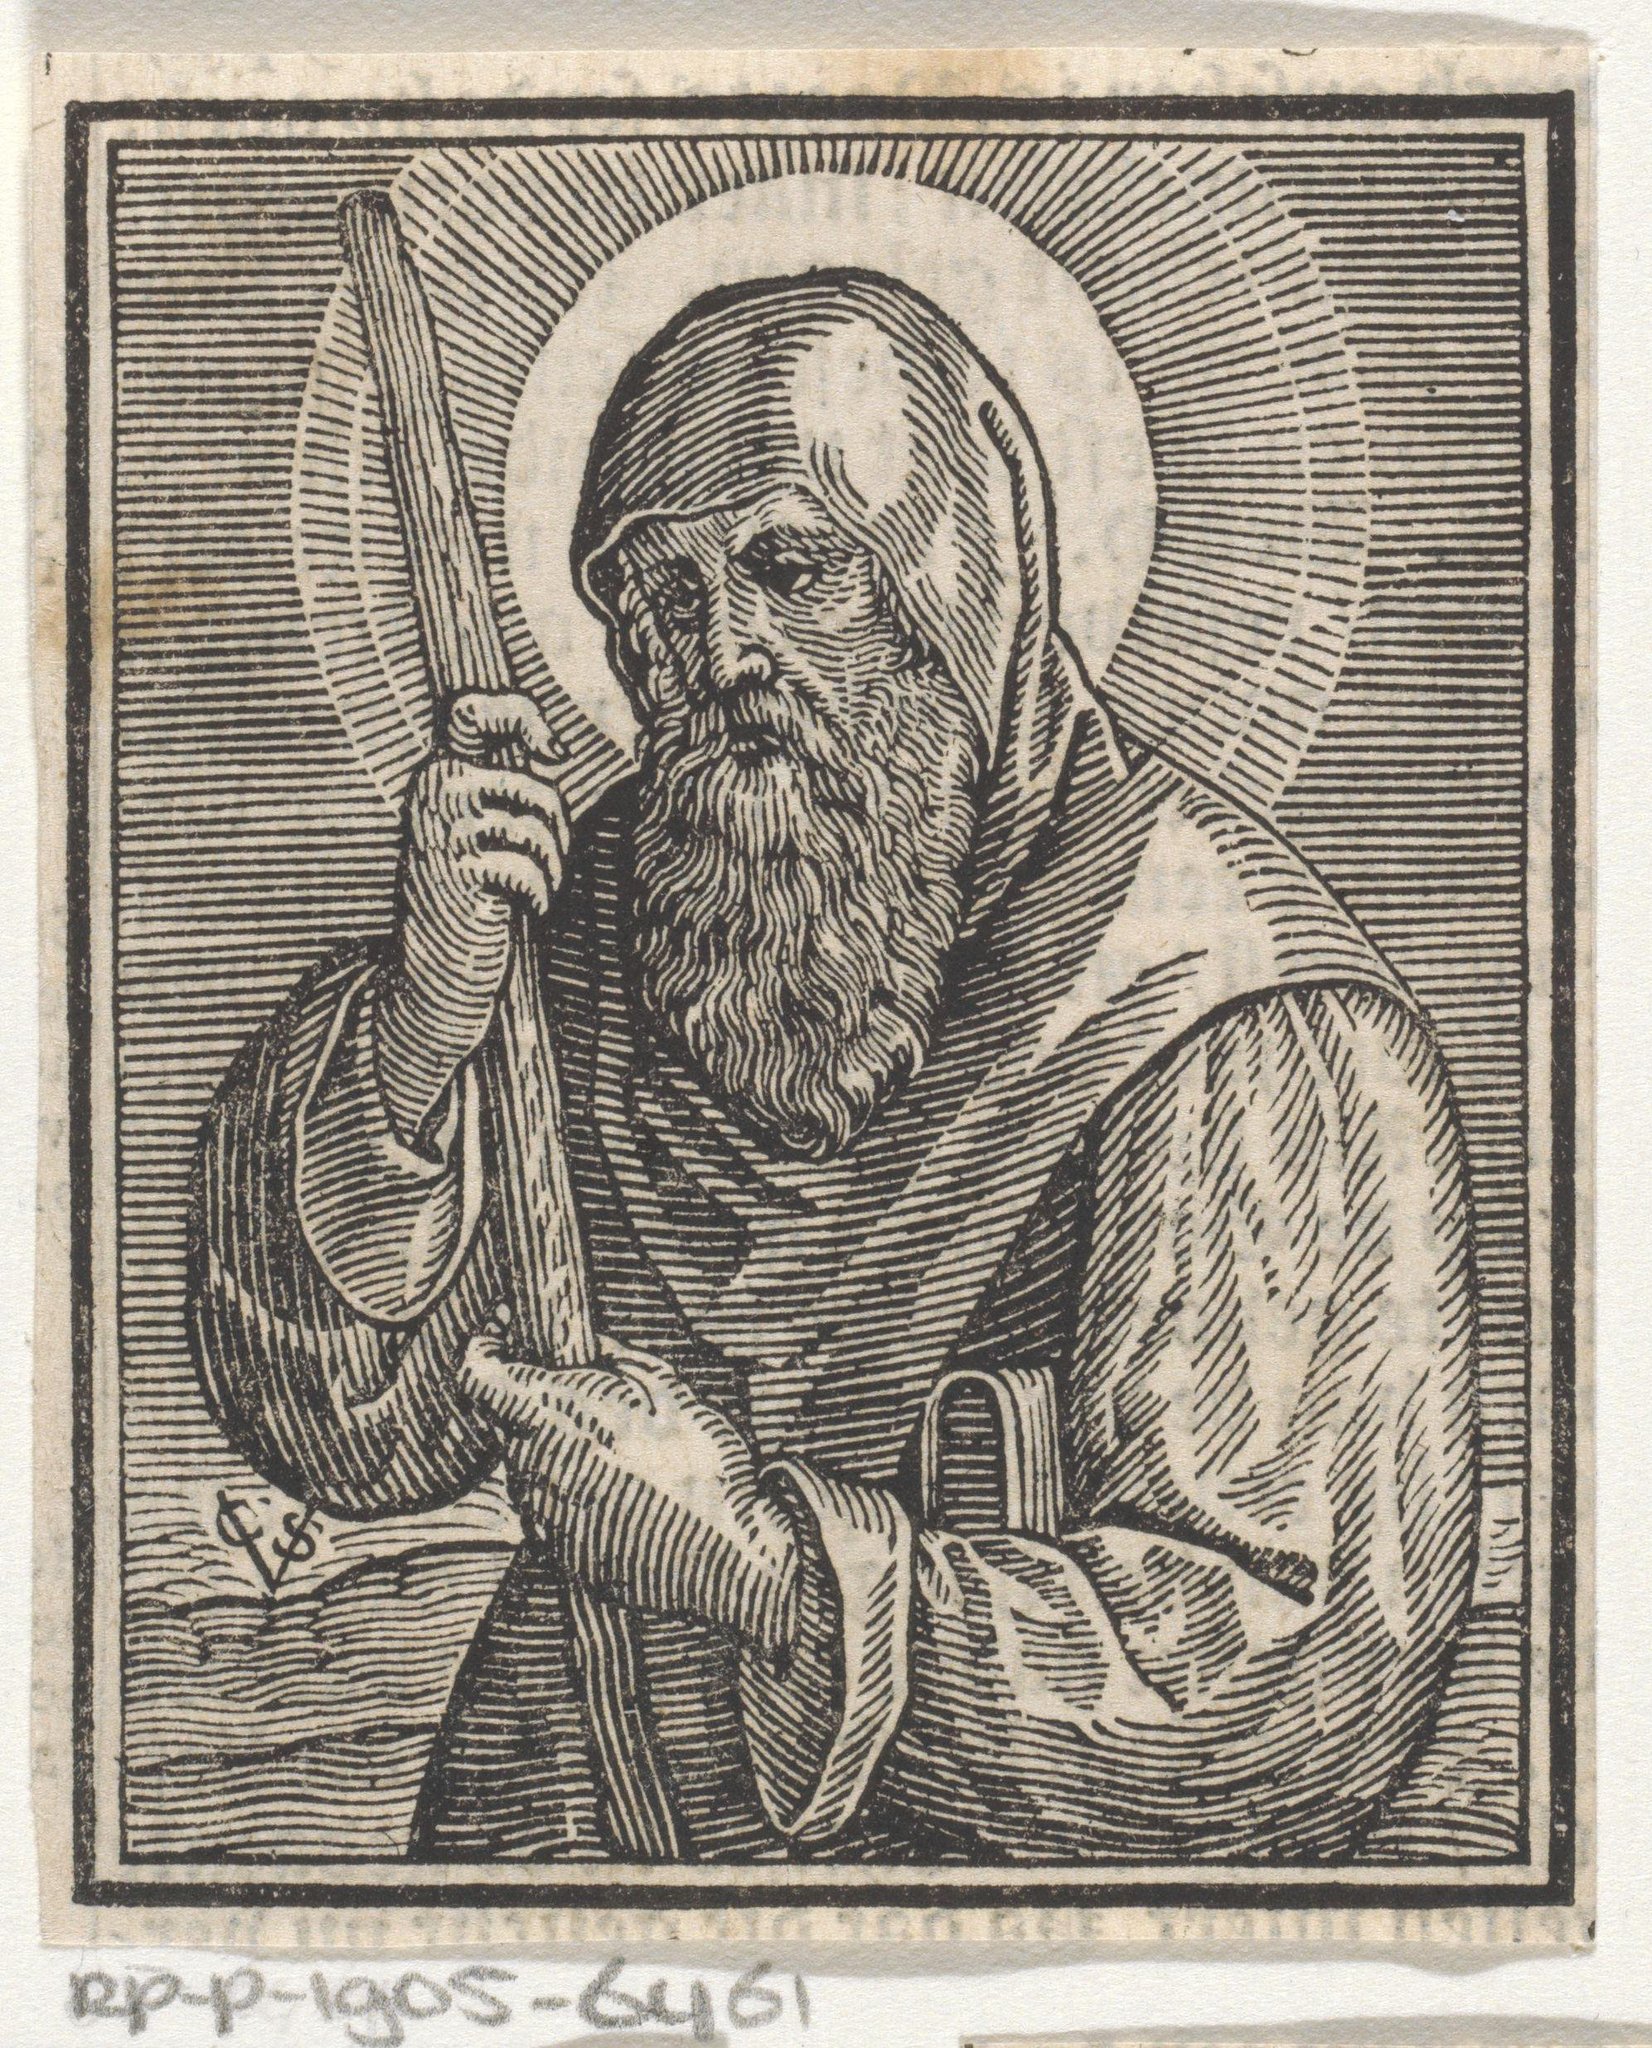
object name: print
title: Heilige met een stok en een boek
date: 1648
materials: paper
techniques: letterpress printing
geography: amsterdam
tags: saints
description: Prent uit: Sichem, Christoffel van (II). 'tSchat der zielen, dat is: Het geheele leven ons Heeren Iesu Christi. Amsterdam: Pieter Jacobsz. Paets, 1648.